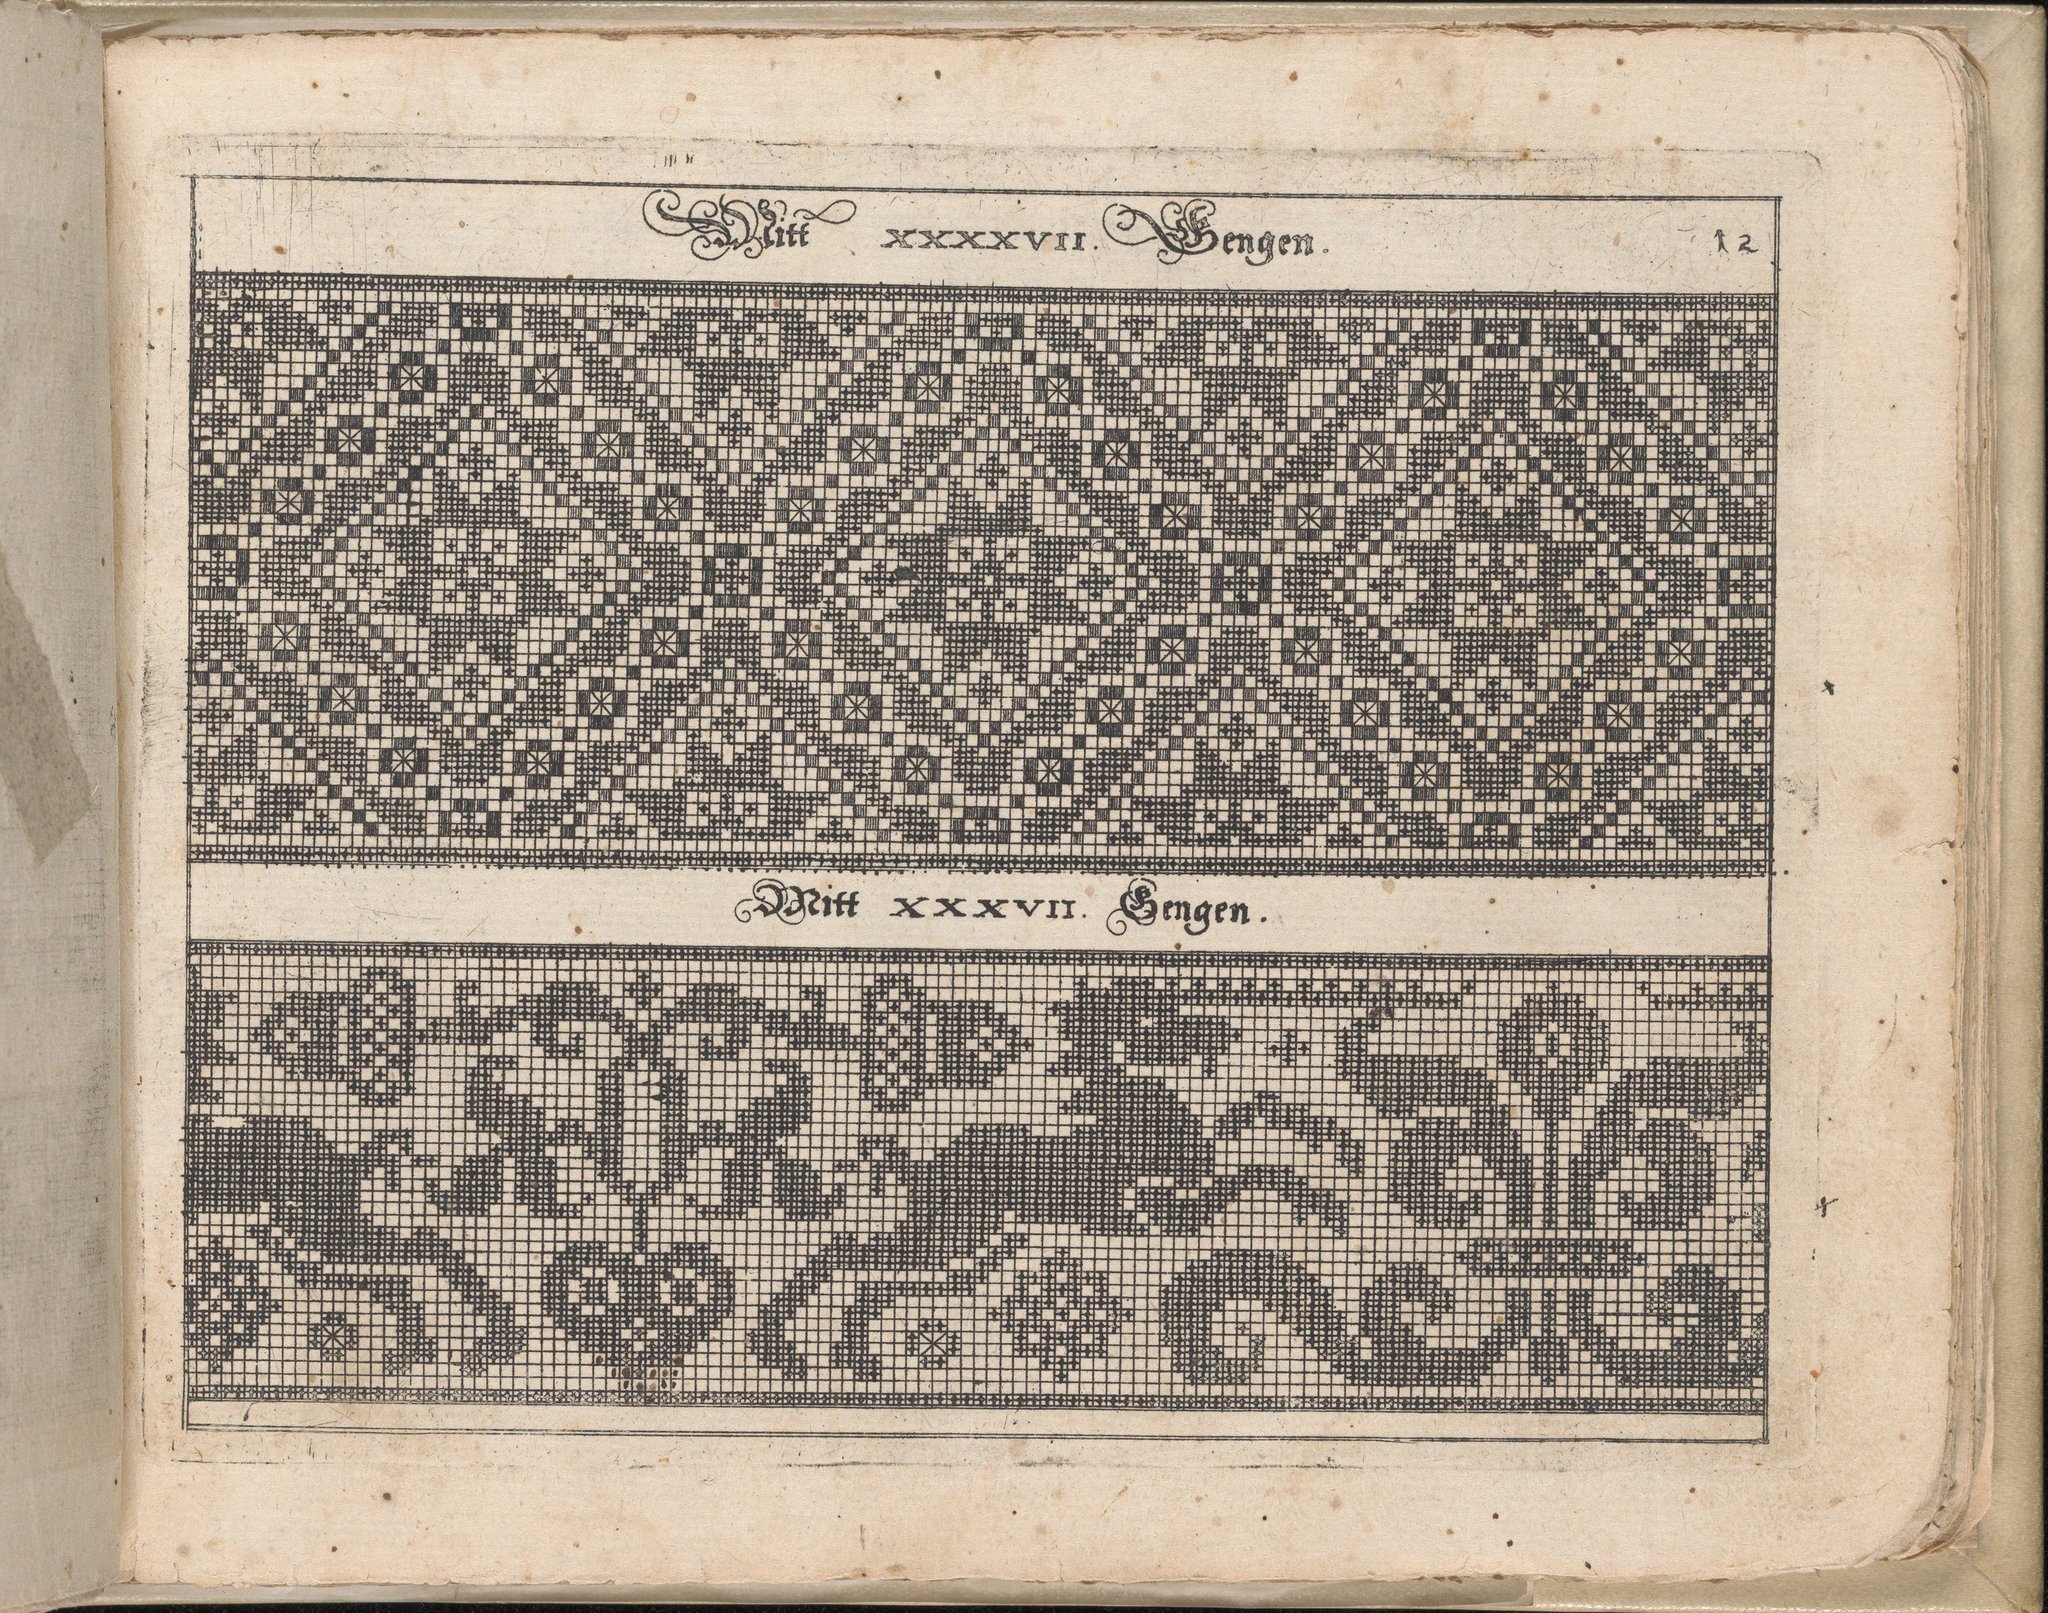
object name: book print ornament architecture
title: Schön Neues Modelbuch (Page 17 recto)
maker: johann sibmacher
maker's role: designer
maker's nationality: german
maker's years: 1590-1611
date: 1597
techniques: etching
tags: ornament,horses